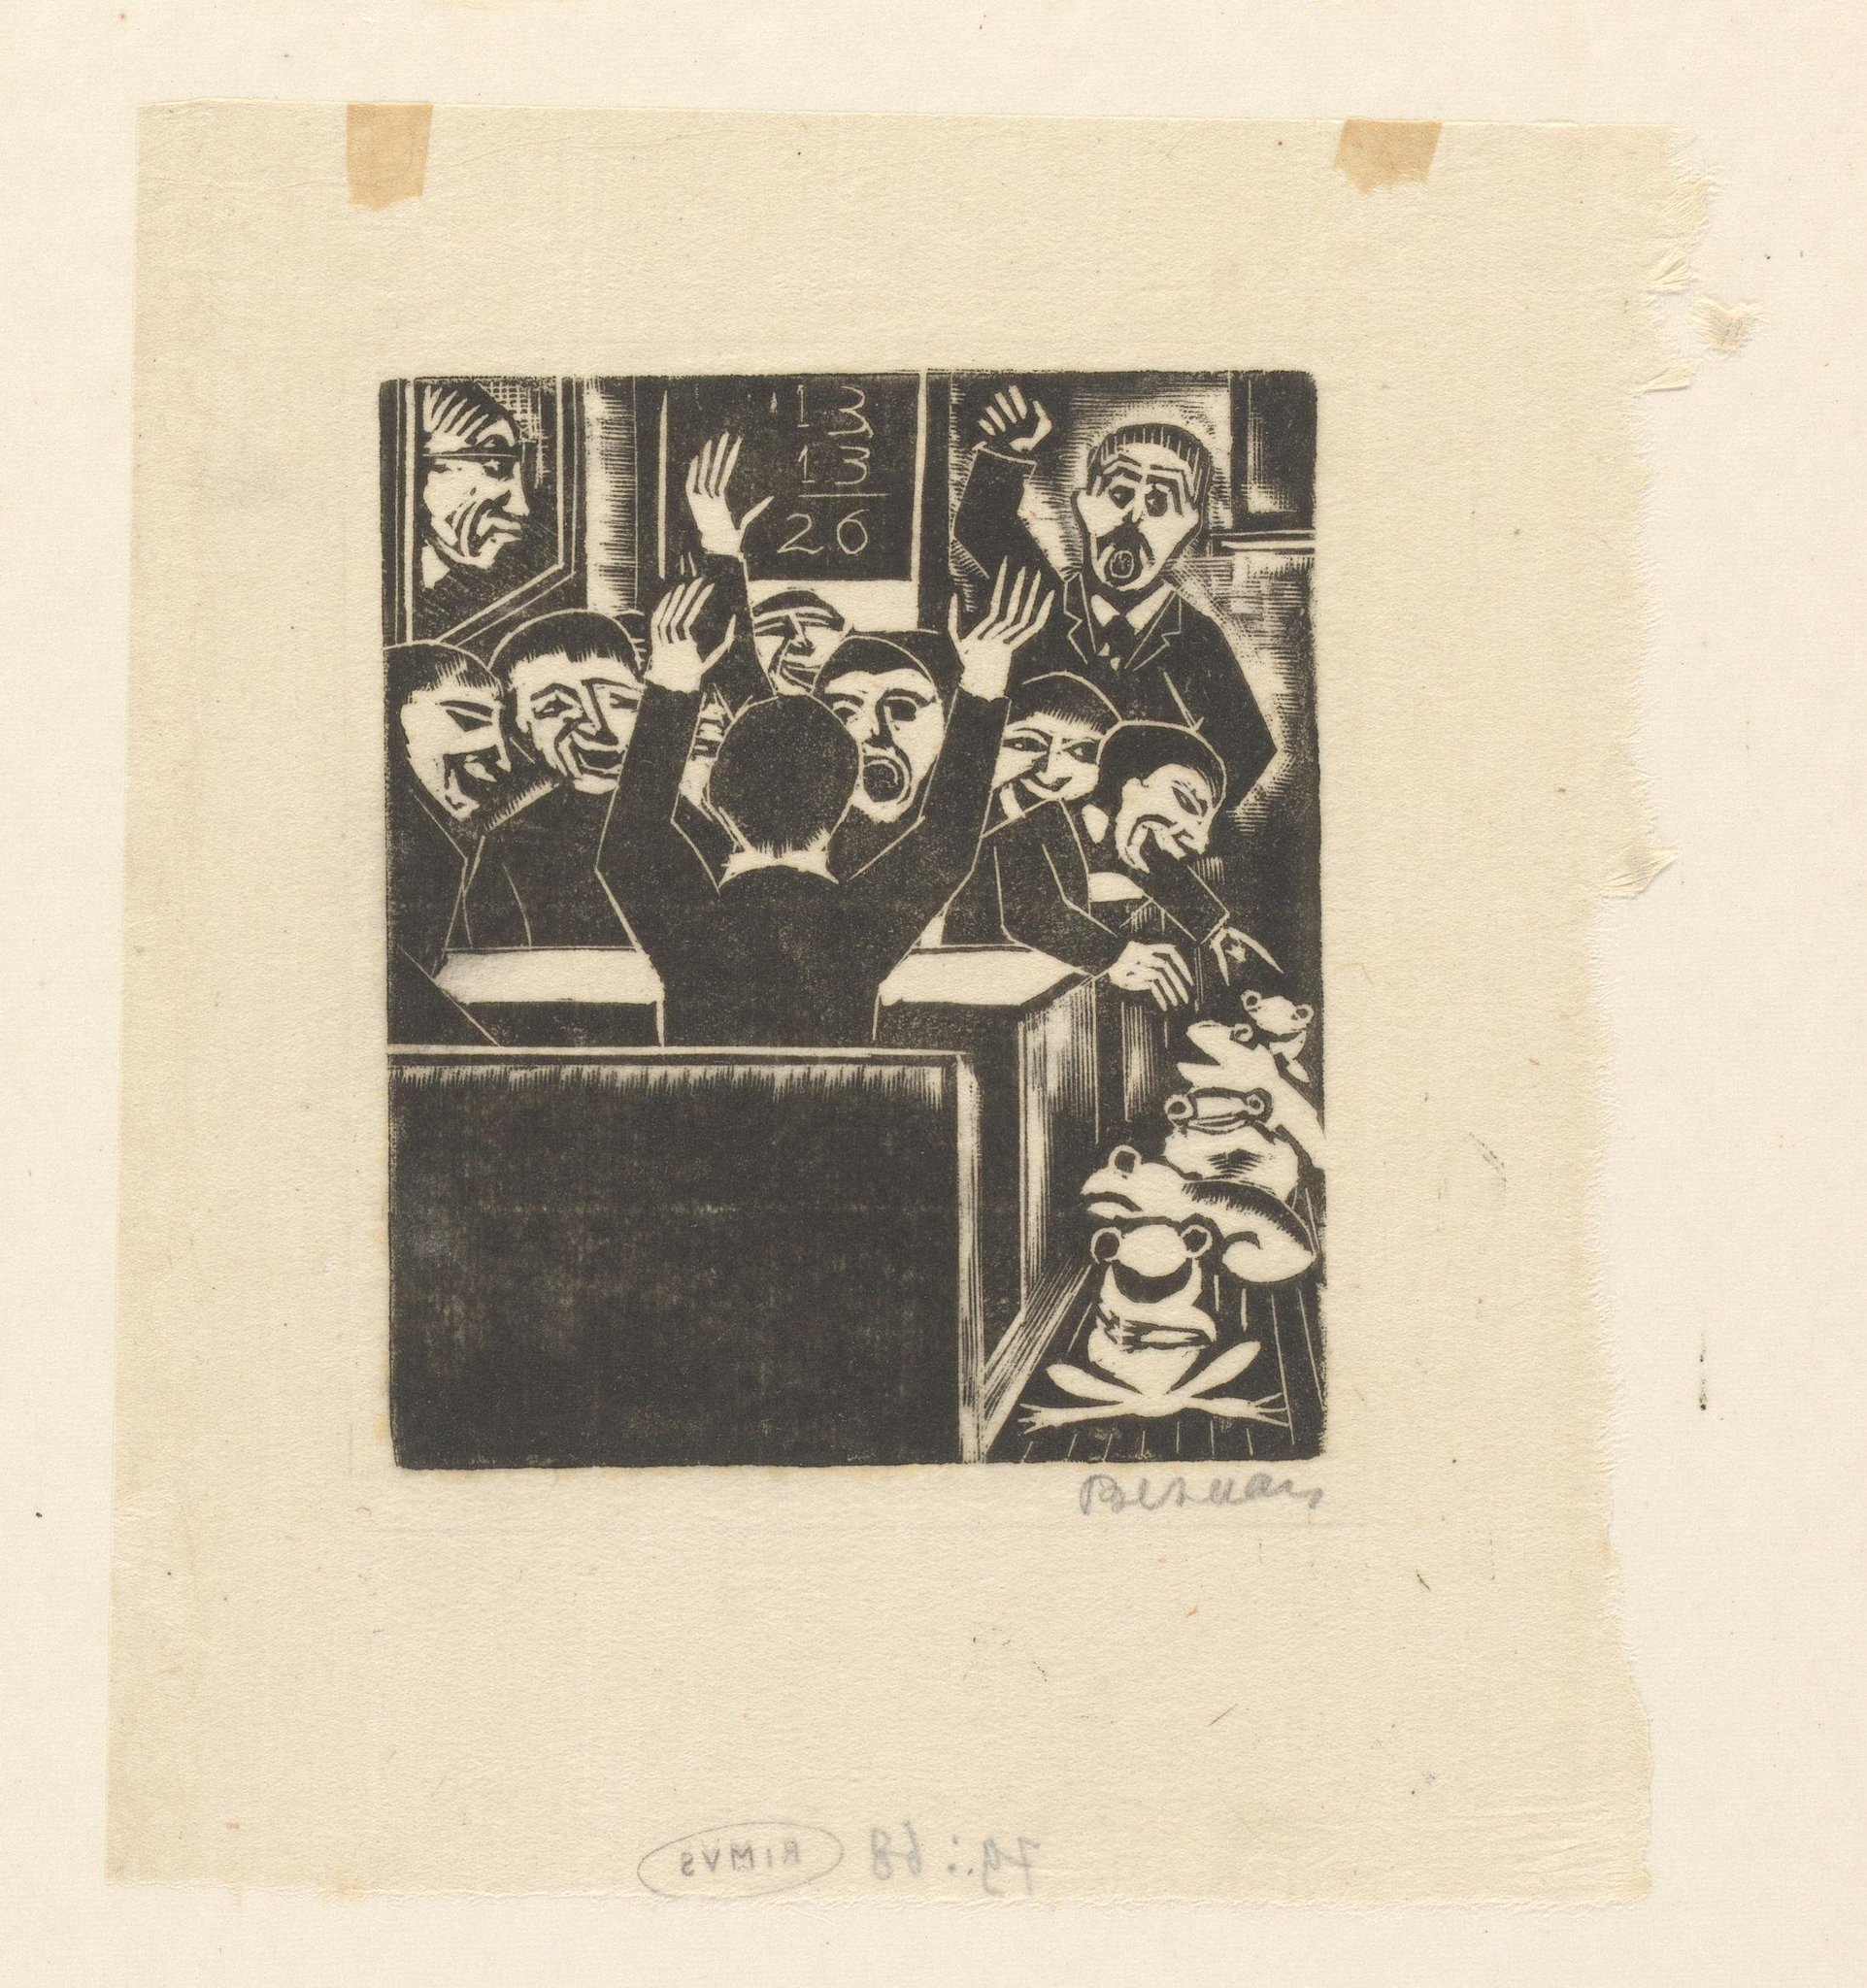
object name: print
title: Rumoerige schoolklas met kikkers op de vloer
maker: jo bezaan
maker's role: draughtsman, print maker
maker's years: 1894-1952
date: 1904-1953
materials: paper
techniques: woodcut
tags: tailless amphibians: frog, teacher and pupil, human figure at (open) window, seen from inside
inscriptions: collector's mark: Lugt 2228